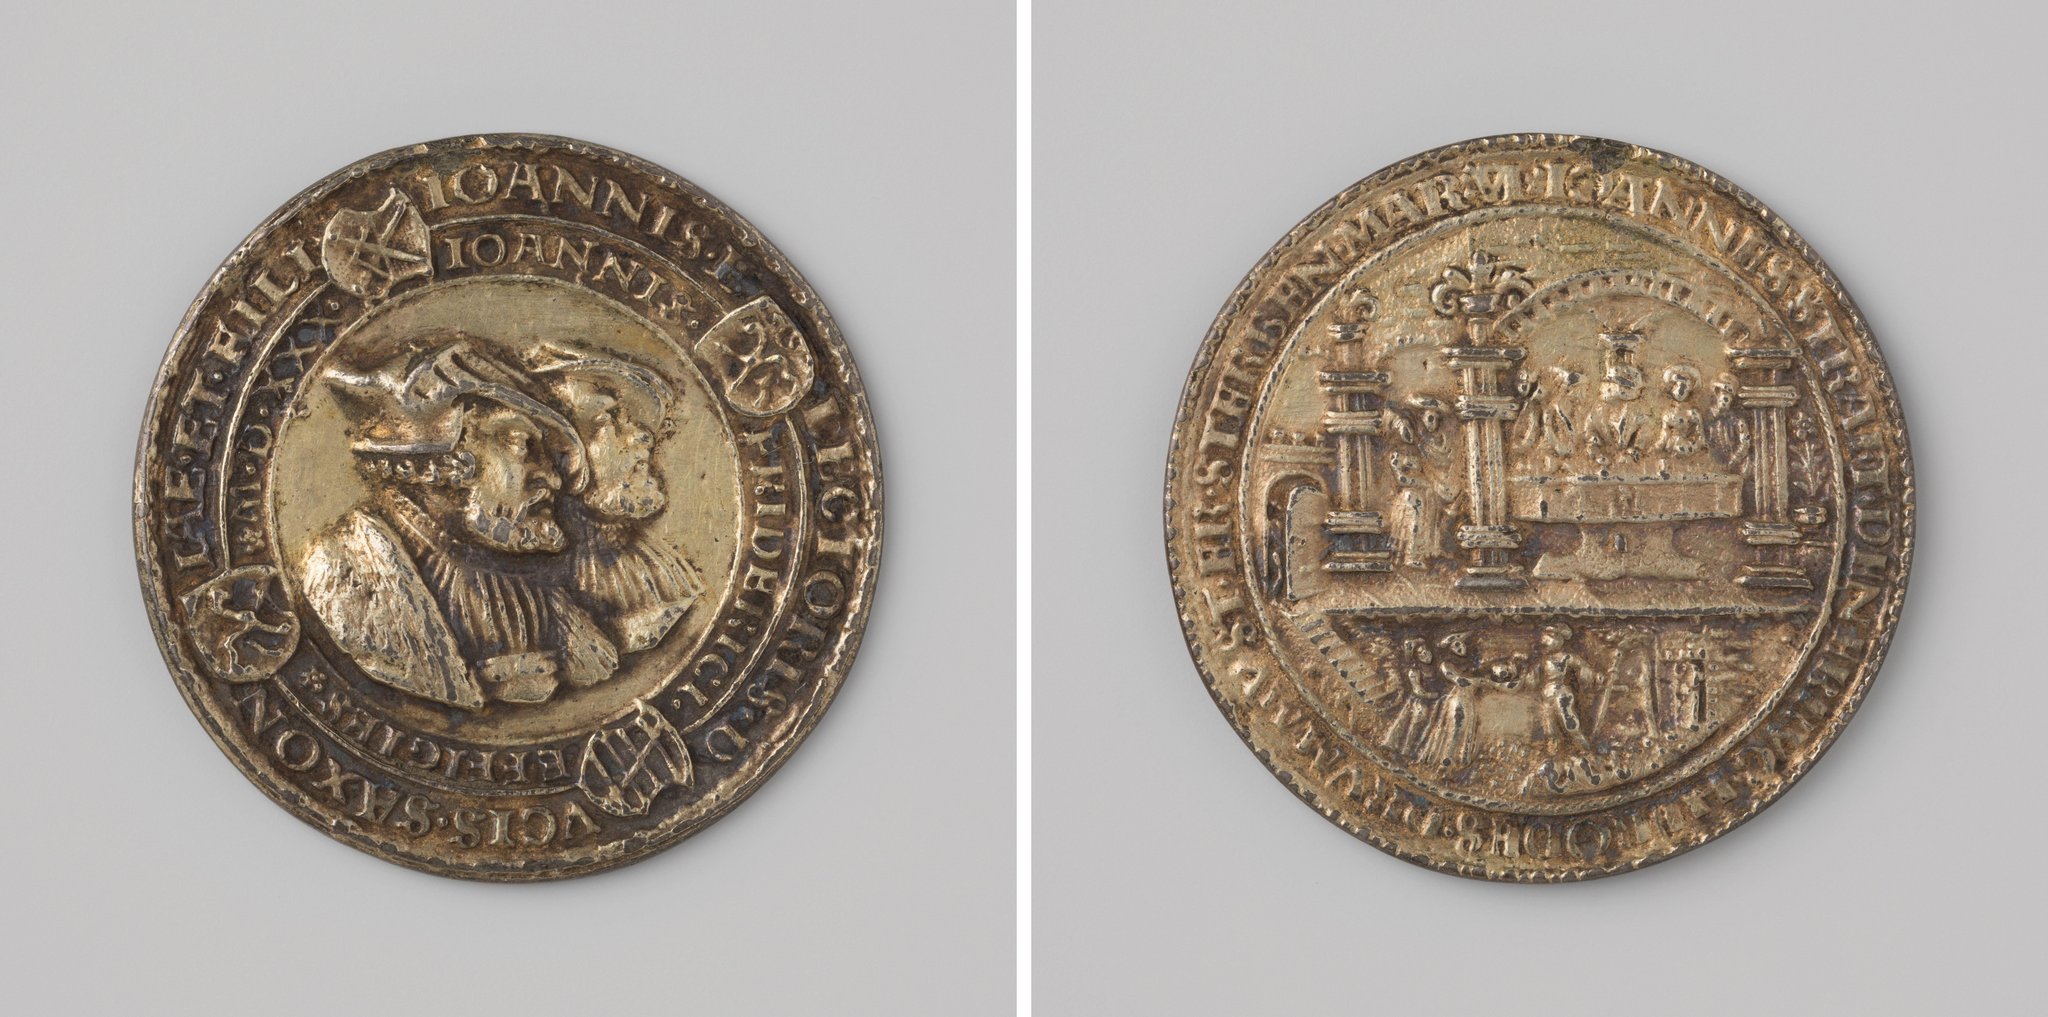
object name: history medal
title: Johan de Standvastige, keurvorst van Saksen en zijn zoon Johan Frederik de Grootmoedige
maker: hieronymus magdeburger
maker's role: die cutter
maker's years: 1492-1540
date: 1530-1531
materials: silver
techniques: casting, gilding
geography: saxony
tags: augsburg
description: Zilveren penning. Voorzijde: borststukken van twee mannen binnen tweeregelig omschrift onderbroken door vier wapenschilden. Keerzijde: gastmaal van Herodes in een zuilenhal; links open deur en trap die naar kerker leidt, waar beul met zwaard nog in zijn handen hoofd van Johannes de Doper op een schotel overhandigt aan Salome, de dochter van Herodes binnen omschrift.